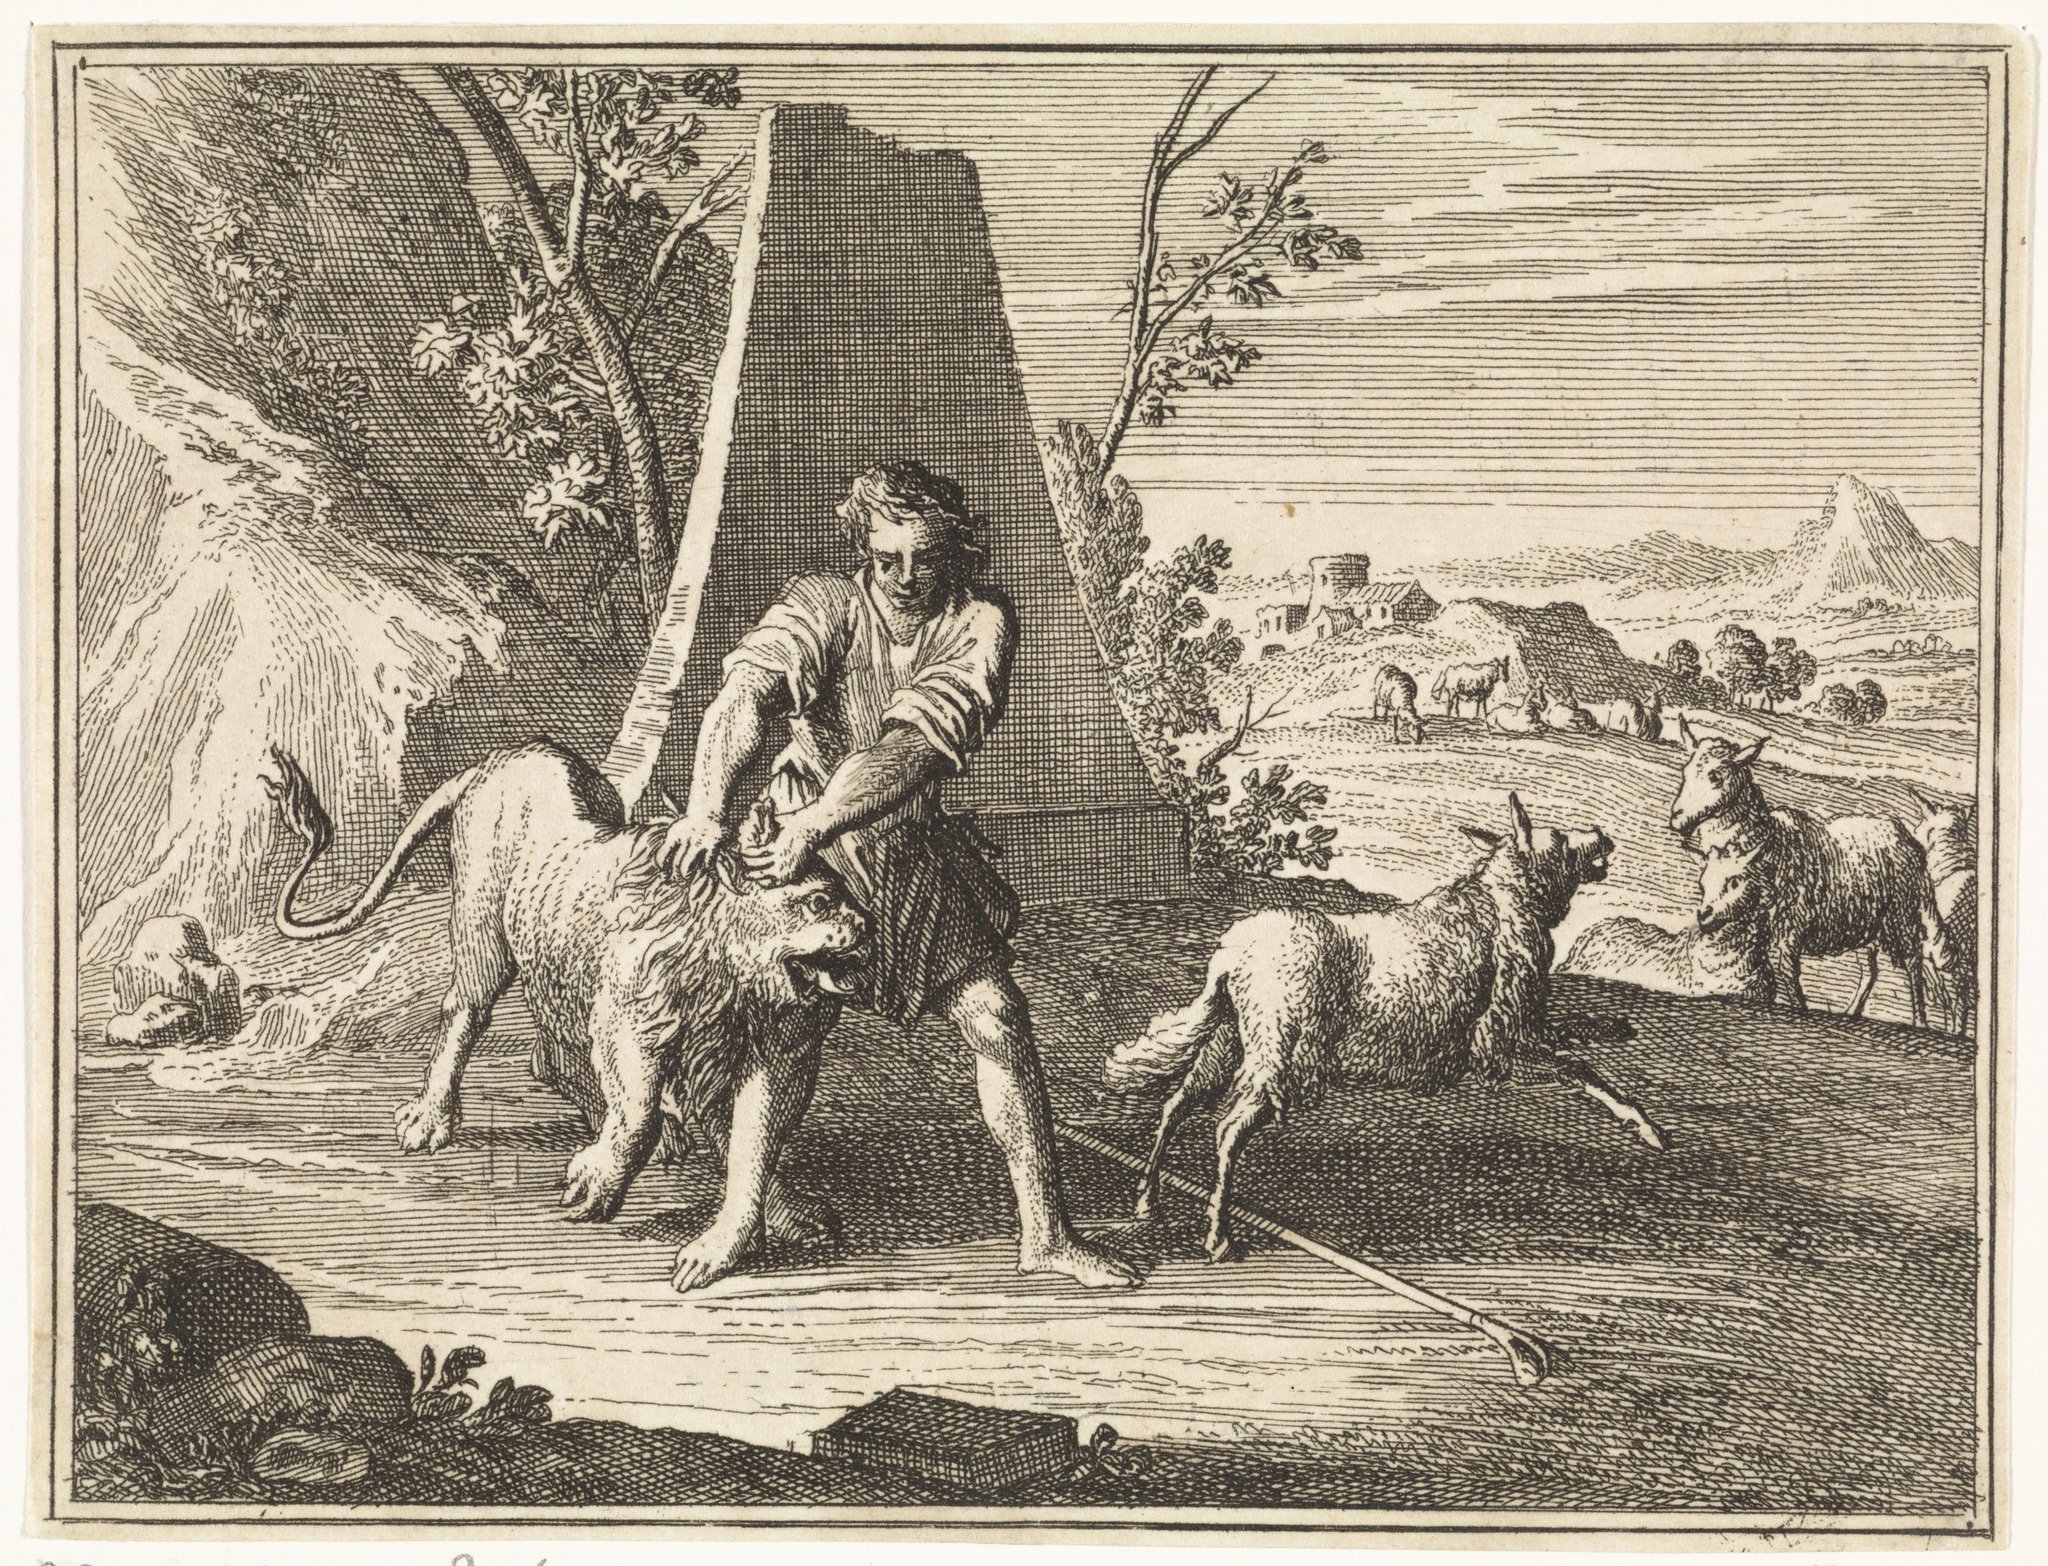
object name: print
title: David verlost een schaap uit de muil van een leeuw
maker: caspar luyken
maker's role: draughtsman, print maker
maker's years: 1672-1708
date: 1712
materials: paper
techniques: etching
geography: amsterdam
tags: david spares nabal's sheep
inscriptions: collector's mark: Lugt 2228, number: ‘102’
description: Illustratie uit: Luyken, Jan. De schriftuurlyke geschiedenissen en gelykenissen van het Oude en Nieuwe Verbond, 2 delen. Amsterdam: Wed. Pieter Arentsz II en Cornelis van der Sys, 1712, dl. I.